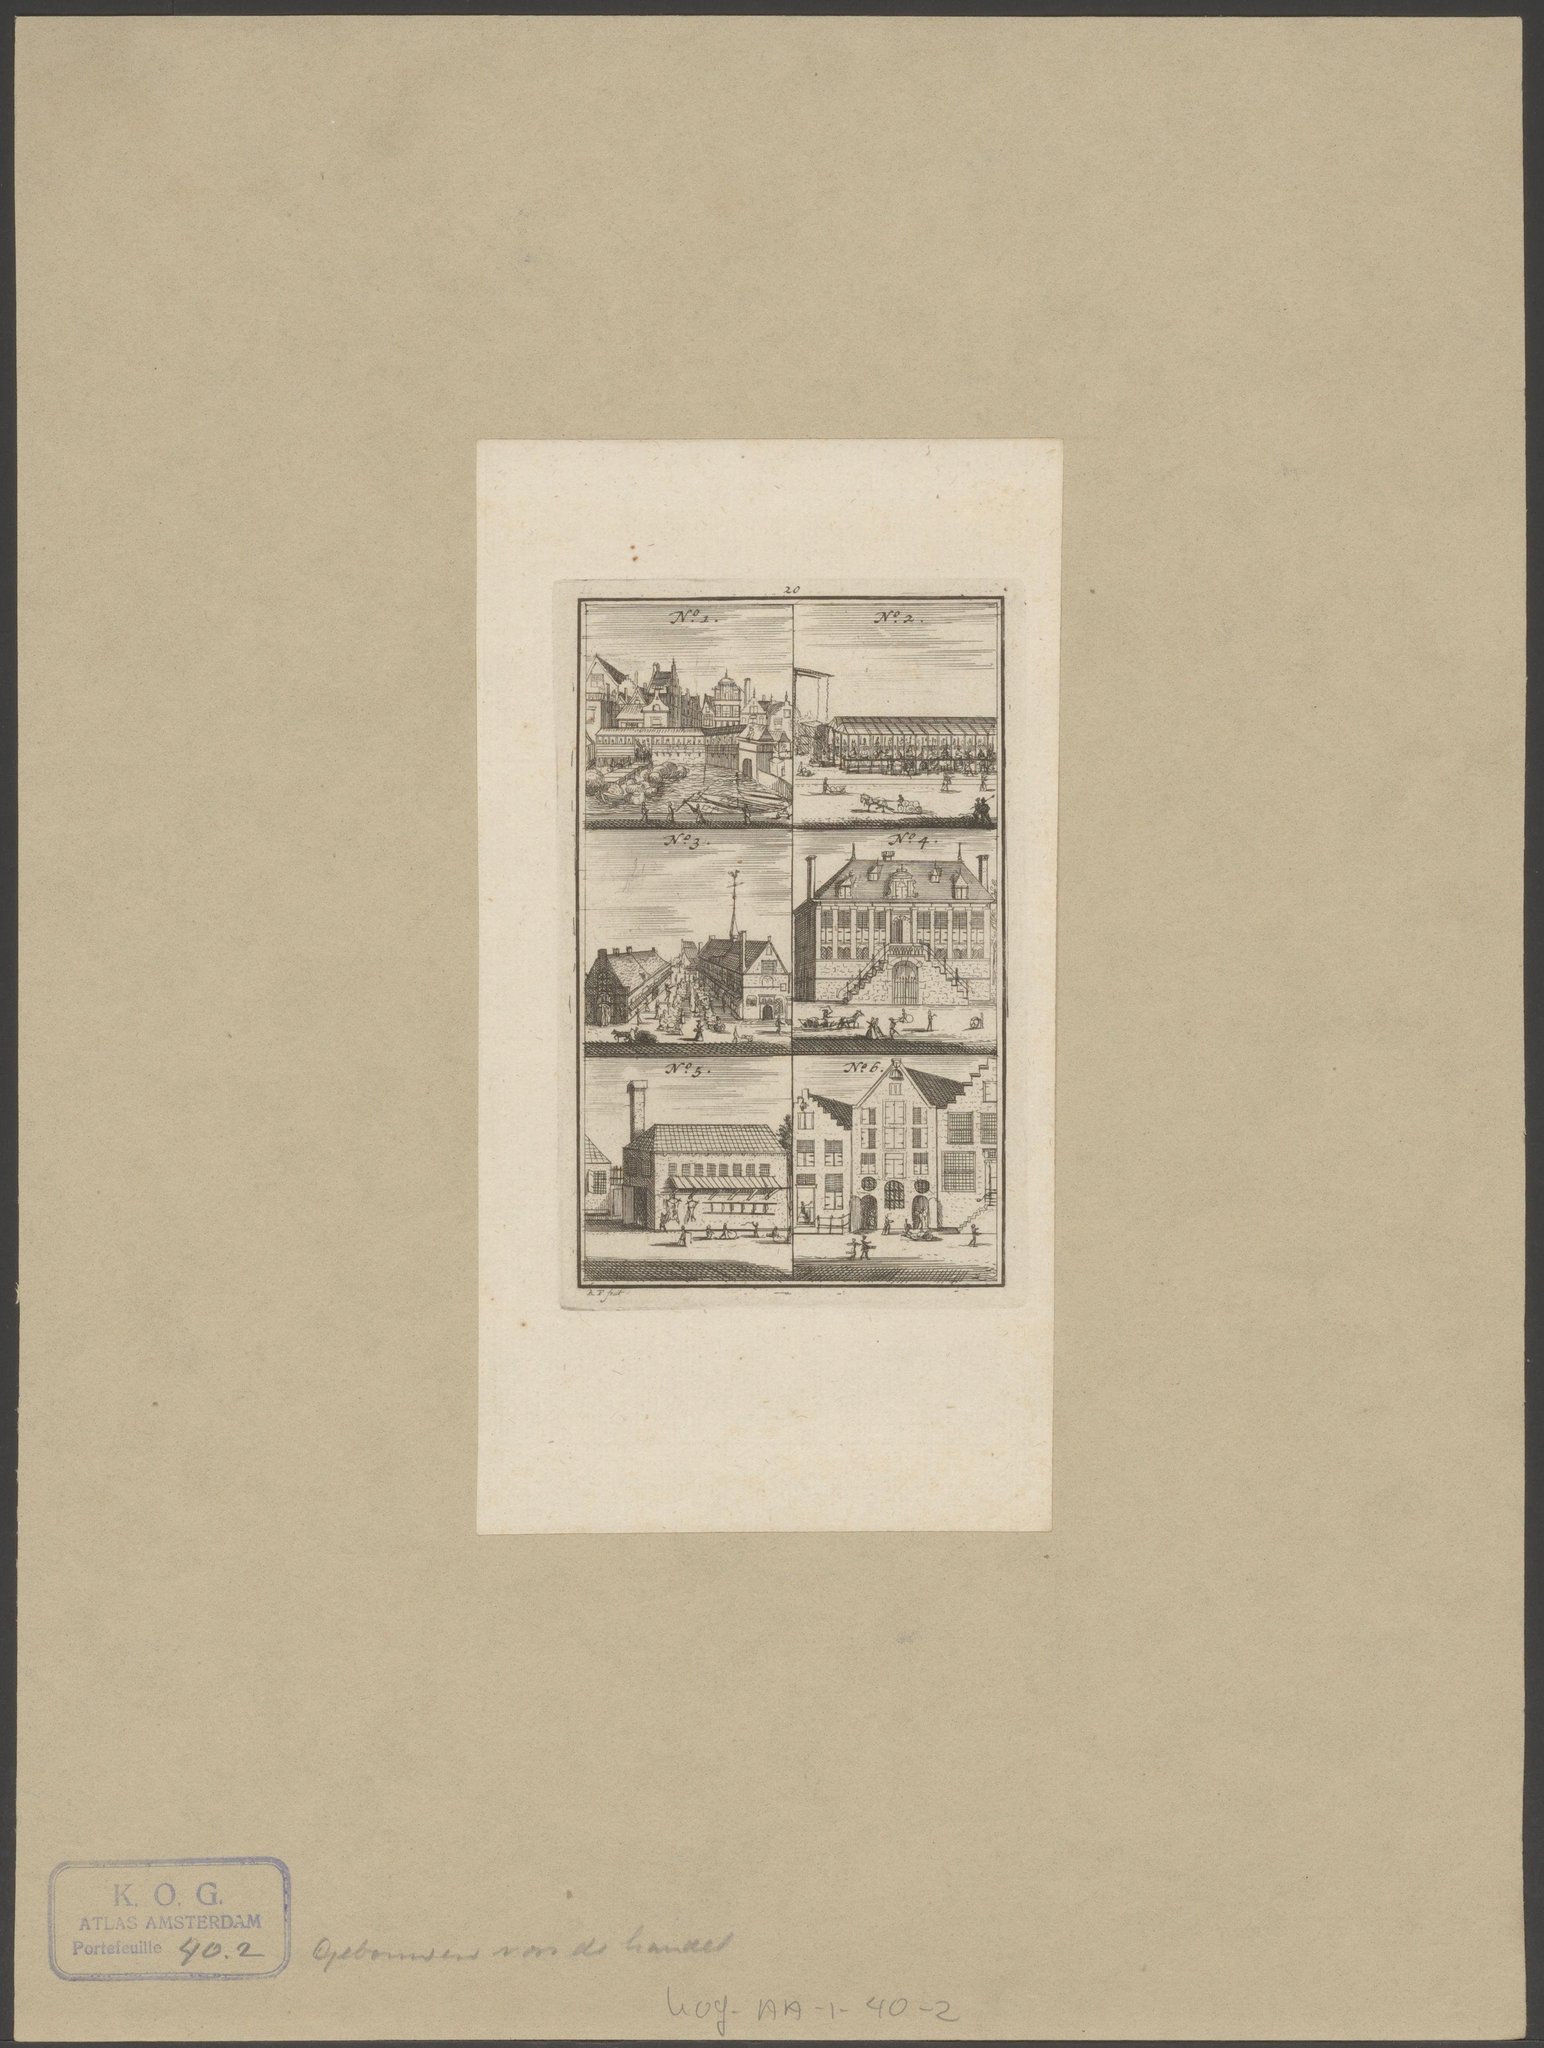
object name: print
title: Zeven verschillende markthallen te Amsterdam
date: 1736-1744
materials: paper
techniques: etching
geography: haarlem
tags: city-view, and landscape with man-made constructions (+ city(-scape) with figures, staffage), market-hall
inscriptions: collector's mark: Lugt 1641b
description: Individuele voorstellingen van de Grote Vismarkt, Nieuwe Vismarkt, Grote Vleeshal, Kleine Vleeshal, Westerhal, Vleeshal op de Herenmarkt en Joodse Vleeshal, genummerd van N° 1 tot en met N° 6. Bovenaan gemerkt: 20. Onderwerpsrubriek binnen de Atlas Amsterdam: Handel en Zeevaart: Verzamelbladen.